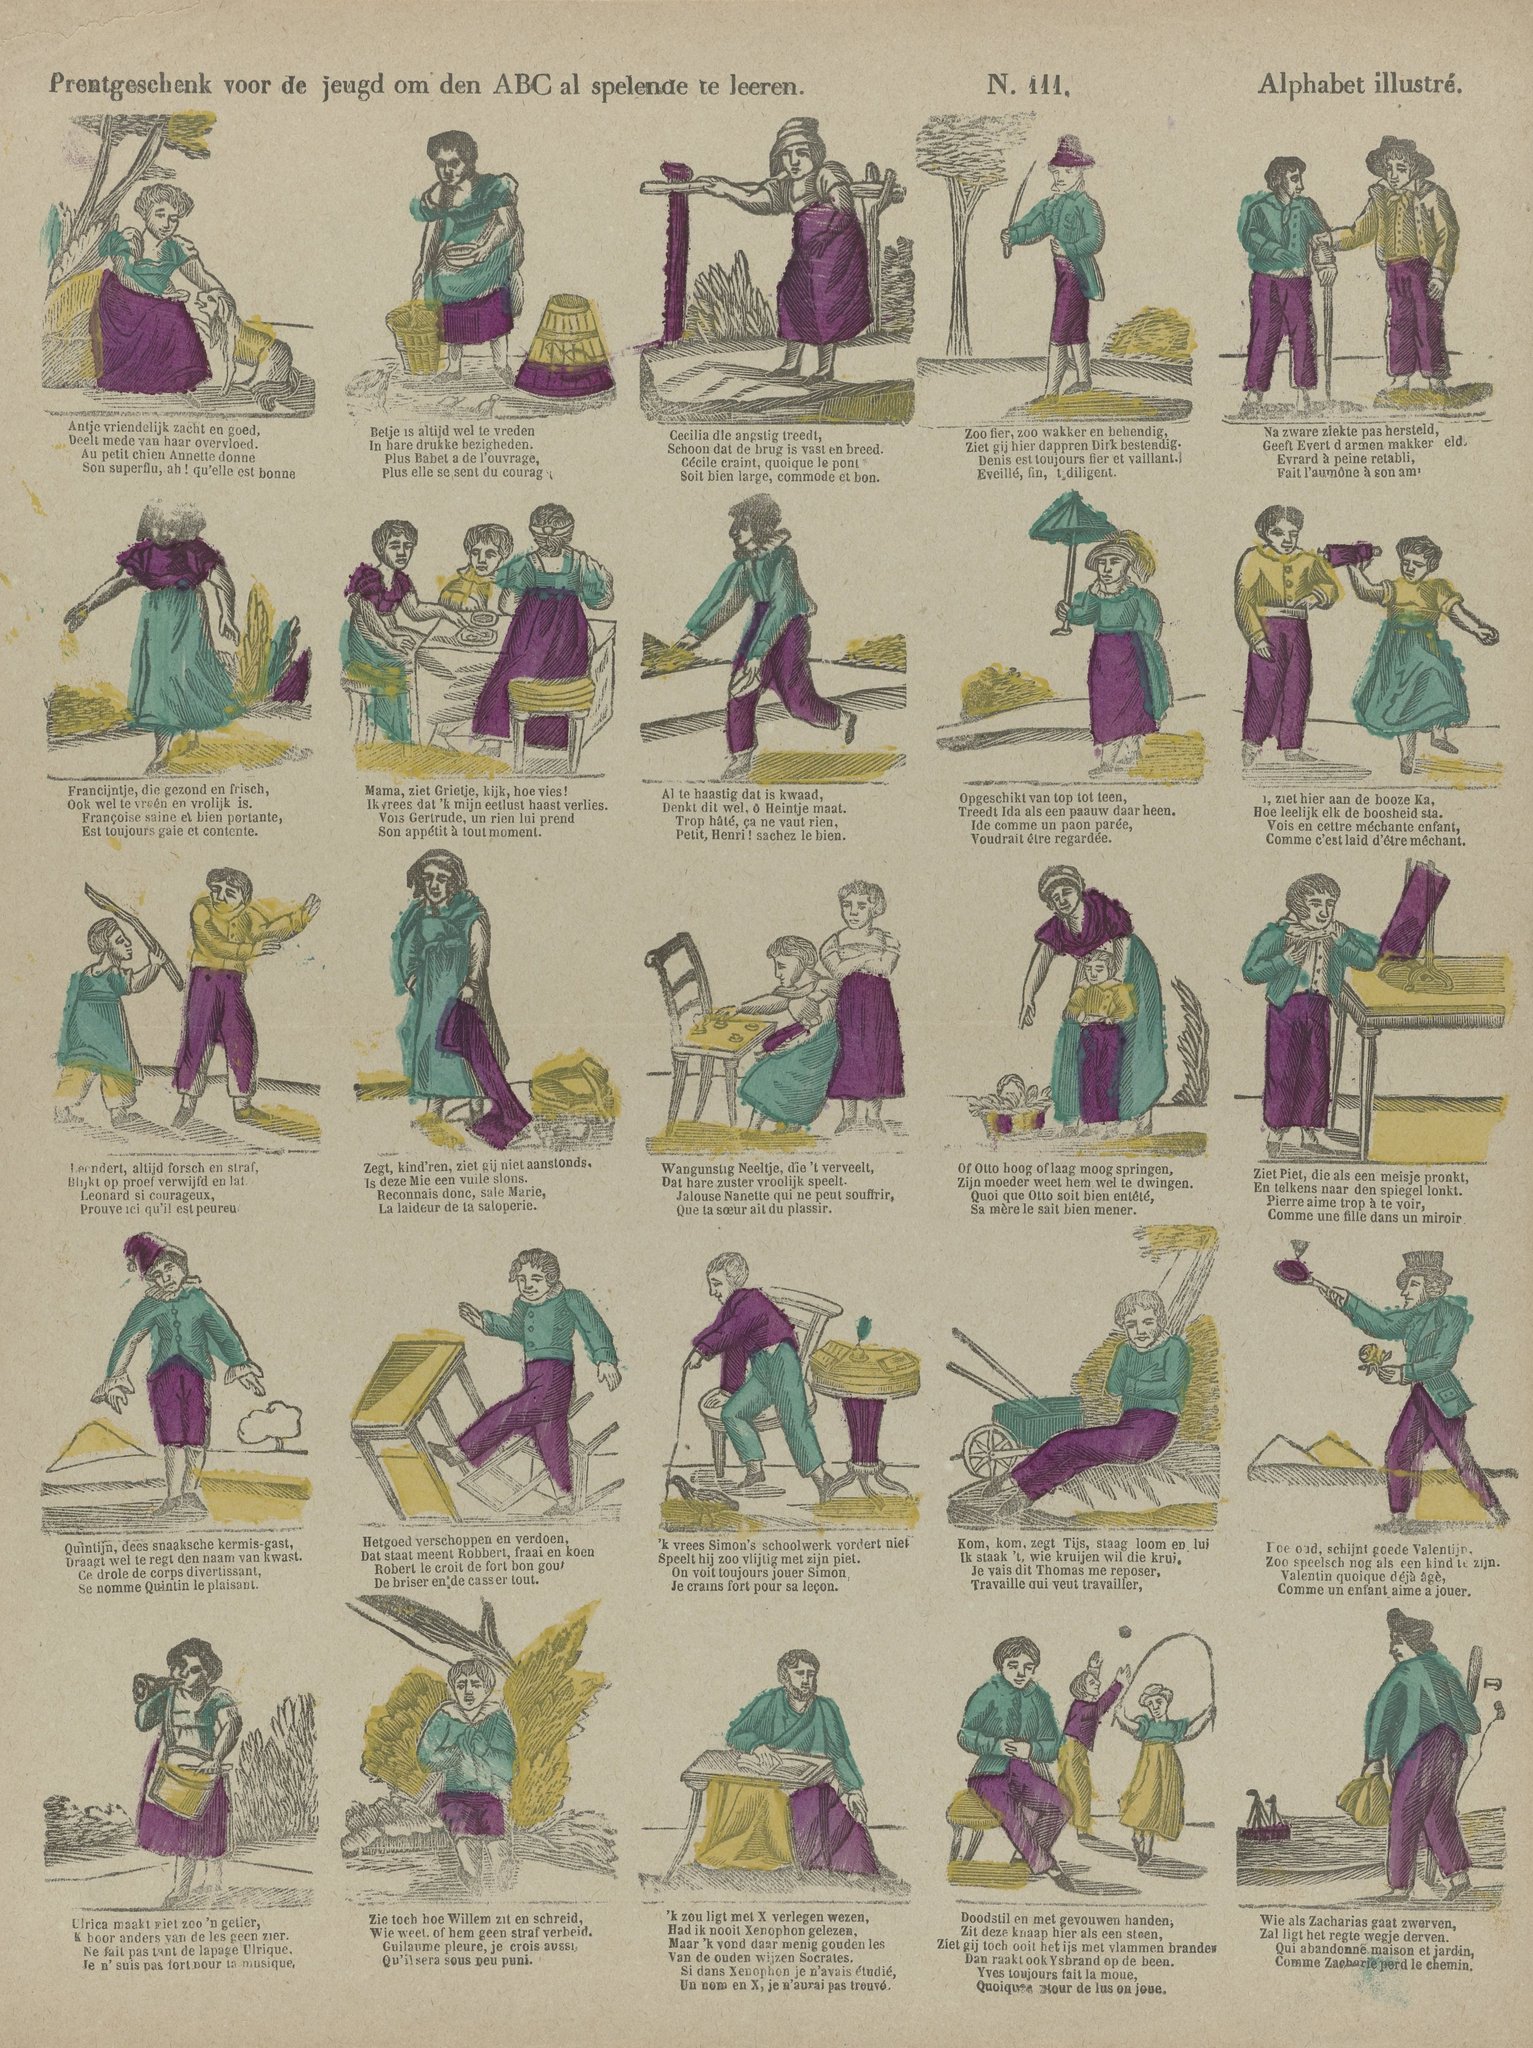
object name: print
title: Prentgeschenk voor de jeugd om den ABC al spelende te leeren / Alphabet illustré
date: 1800-1833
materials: paper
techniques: colour, letterpress printing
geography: turnhout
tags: letters, alphabet, script, bad behaviour, good behaviour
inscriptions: collector's mark: Lugt 2760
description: Blad met 25 voorstellingen van het alphabet met deugden en ondeugden van de jeugd. Onder elke voorstelling een tweeregelig vers in het Nederlands en in het Frans. Genummerd midden boven: N. 111.